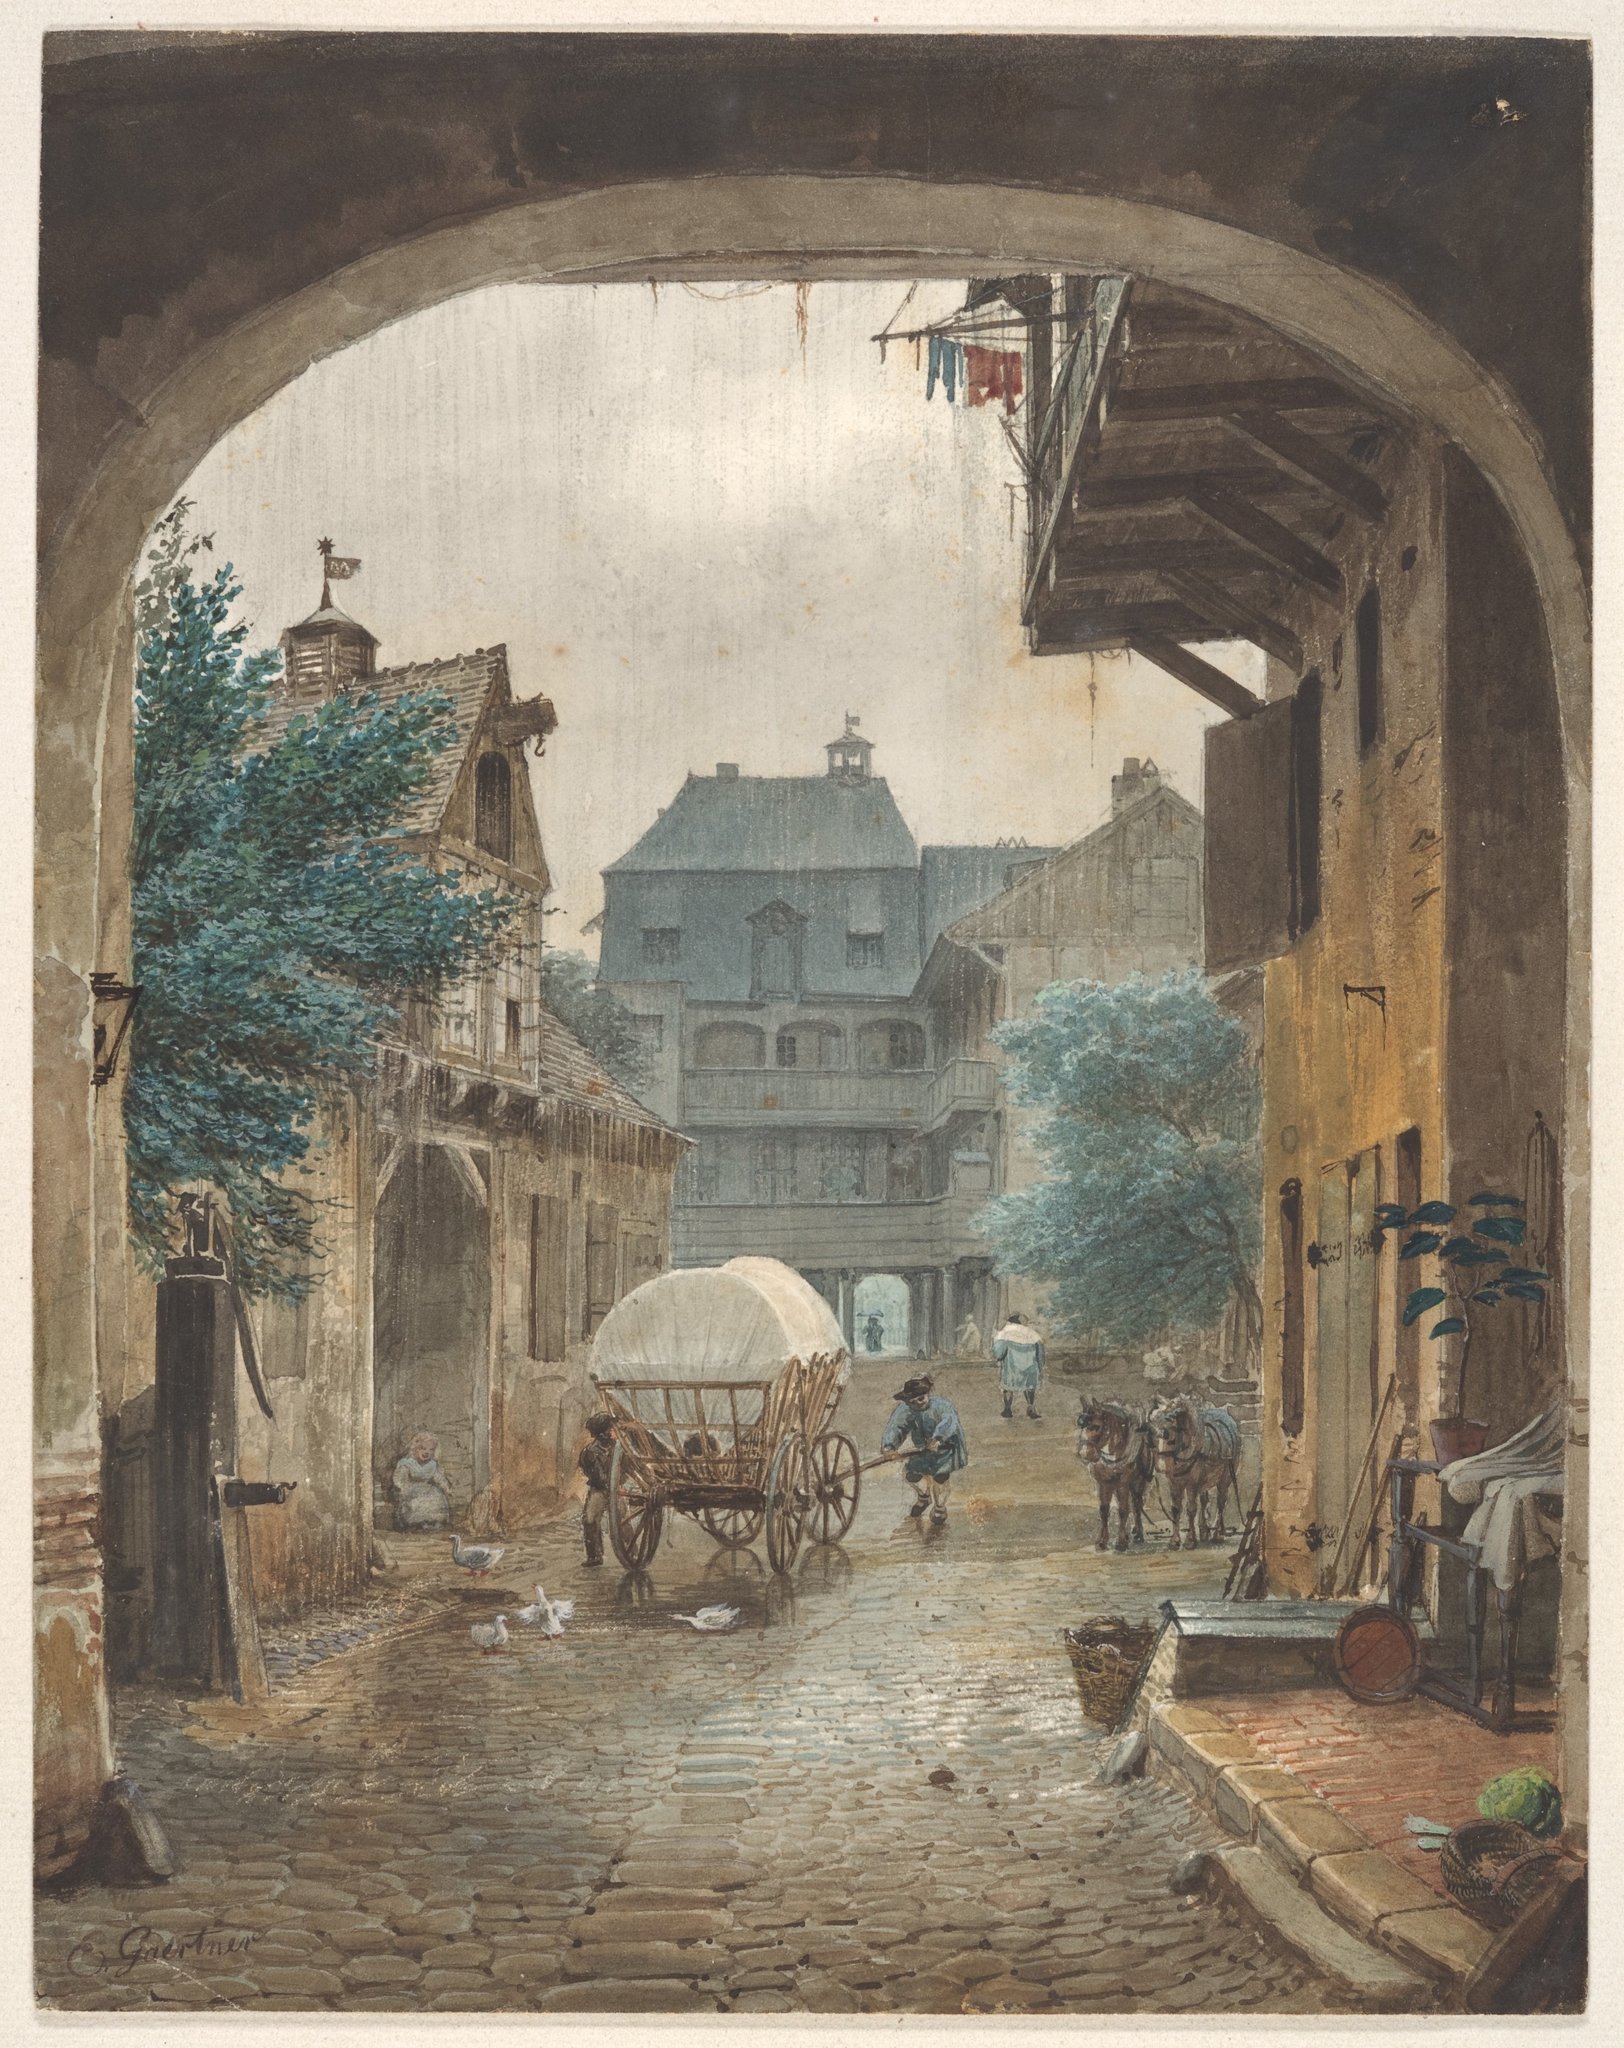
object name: drawing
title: View into the Courtyard of an Inn at Colmar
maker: eduard gaertner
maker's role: artist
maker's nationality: german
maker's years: 1801-1877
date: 1821-1877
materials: graphite, watercolor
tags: inns,courtyards,men,horses,carriages